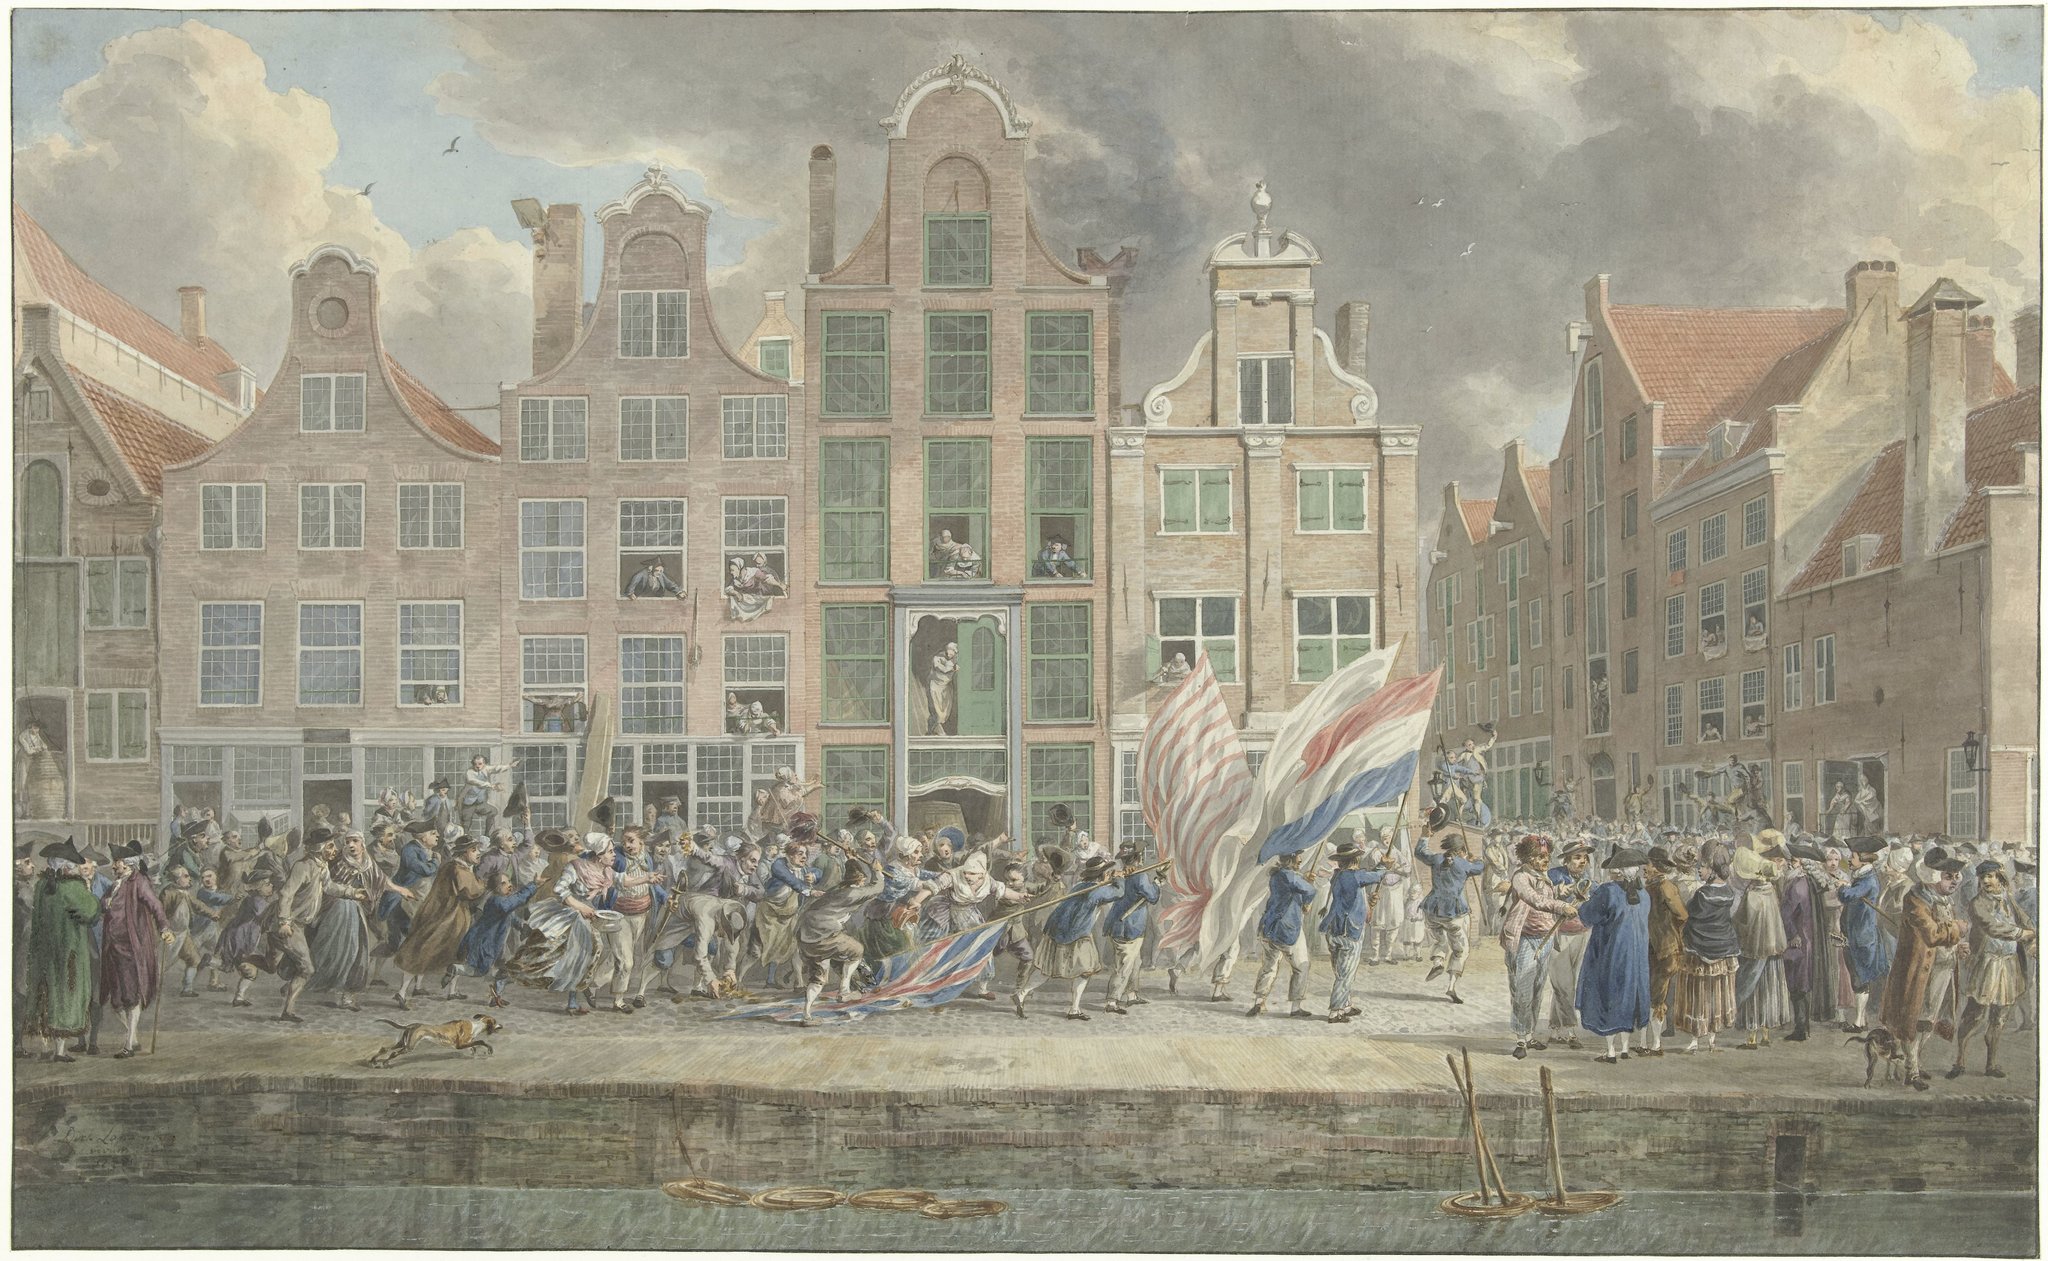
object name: drawing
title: Anti-Engelse demonstratie te Rotterdam, 2 maart 1781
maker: dirk langendijk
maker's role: draughtsman, painter, print maker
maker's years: 1748-1805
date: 1781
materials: paper, watercolor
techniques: brush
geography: northern netherlands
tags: political demonstration, united states of america, rotterdam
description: Een anti-Engelse manifestatie te Rotterdam (Glashaven, hoek Oranjestraat), 2 maart 1781. Onder grote publieke belangstelling lopen matrozen met een Nederlandse, Amerikaanse en Franse (?) vlag terwijl een Britse vlag over de stenen wordt gesleept en vertrapt.